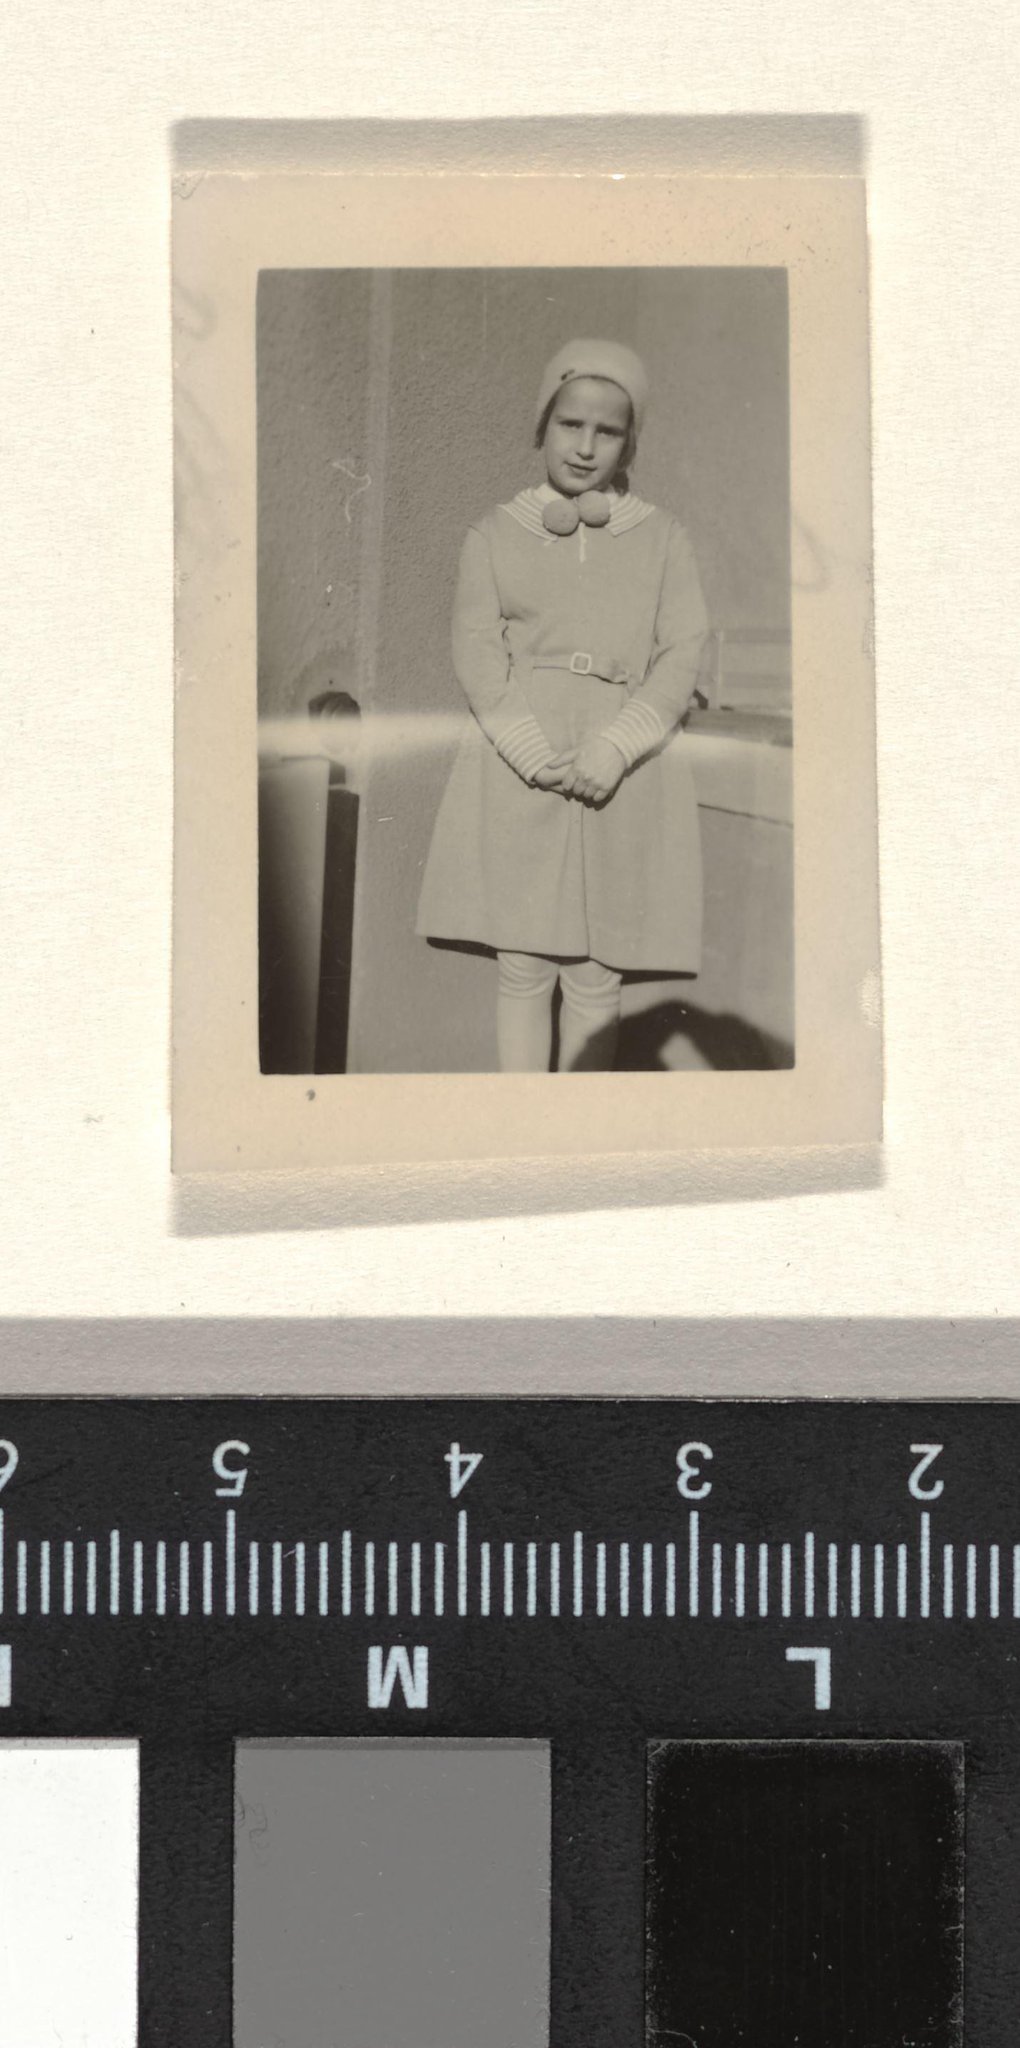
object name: photograph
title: Isabel Wachenheimer met een muts op haar hoofd en bolletjes om haar nek voor een muur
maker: Anonymous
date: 1933-1936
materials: photographic support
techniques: gelatin silver print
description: Isabel Wachenheimer met een muts op haar hoofd en bolletjes om haar nek voor een muur.